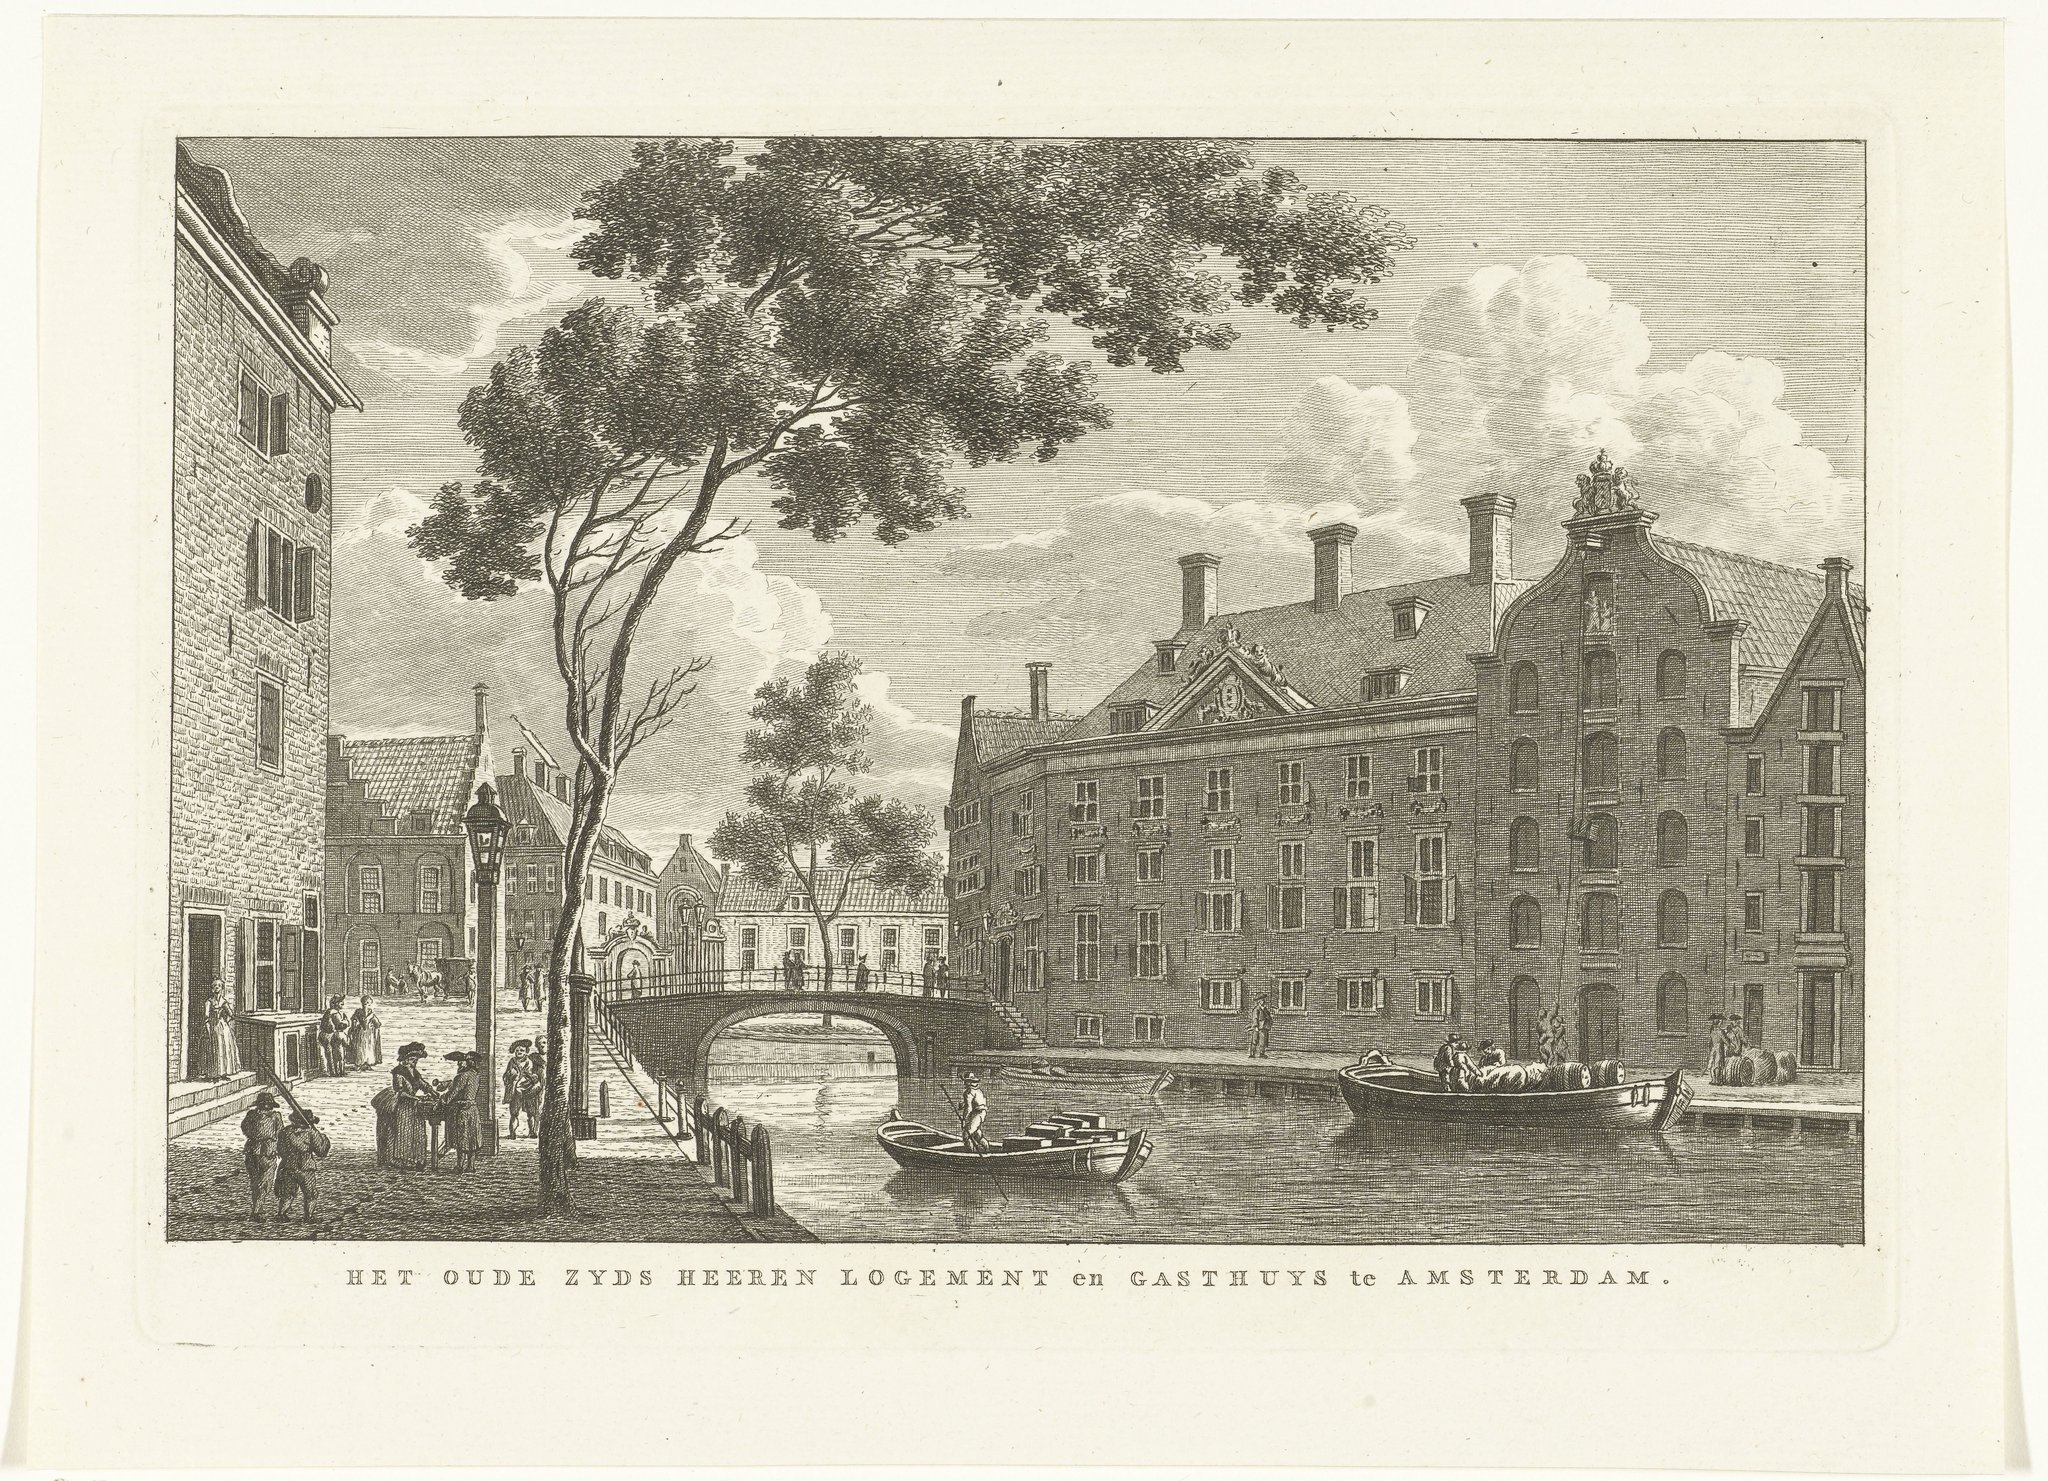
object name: print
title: Stadsgezicht met Oudezijds Herenlogement en Gasthuis te Amsterdam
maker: carel frederik bendorp (i)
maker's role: print maker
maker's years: 1736-1814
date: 1786-1792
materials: paper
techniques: etching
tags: hospital, auction sale, public sale, amsterdam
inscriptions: collector's mark: Lugt 2228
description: Prent uit: Vaderlandsche gezichten, of afbeeldingen van den tegenwoordigen staat der Vereenigde Nederlanden (…). Amsterdam: Hendrik Gartman, Willem Vermandel en Jan Willem Smit, 1786-1792. Uitgegeven in afleveringen met ieder een eigen bifolium en inhoudsopgave. Alle prenten in deze publicatie zijn gegraveerd door Carel Frederik Bendorp (I) en, in de meeste gevallen, gebaseerd op tekeningen van Jan Bulthuis.